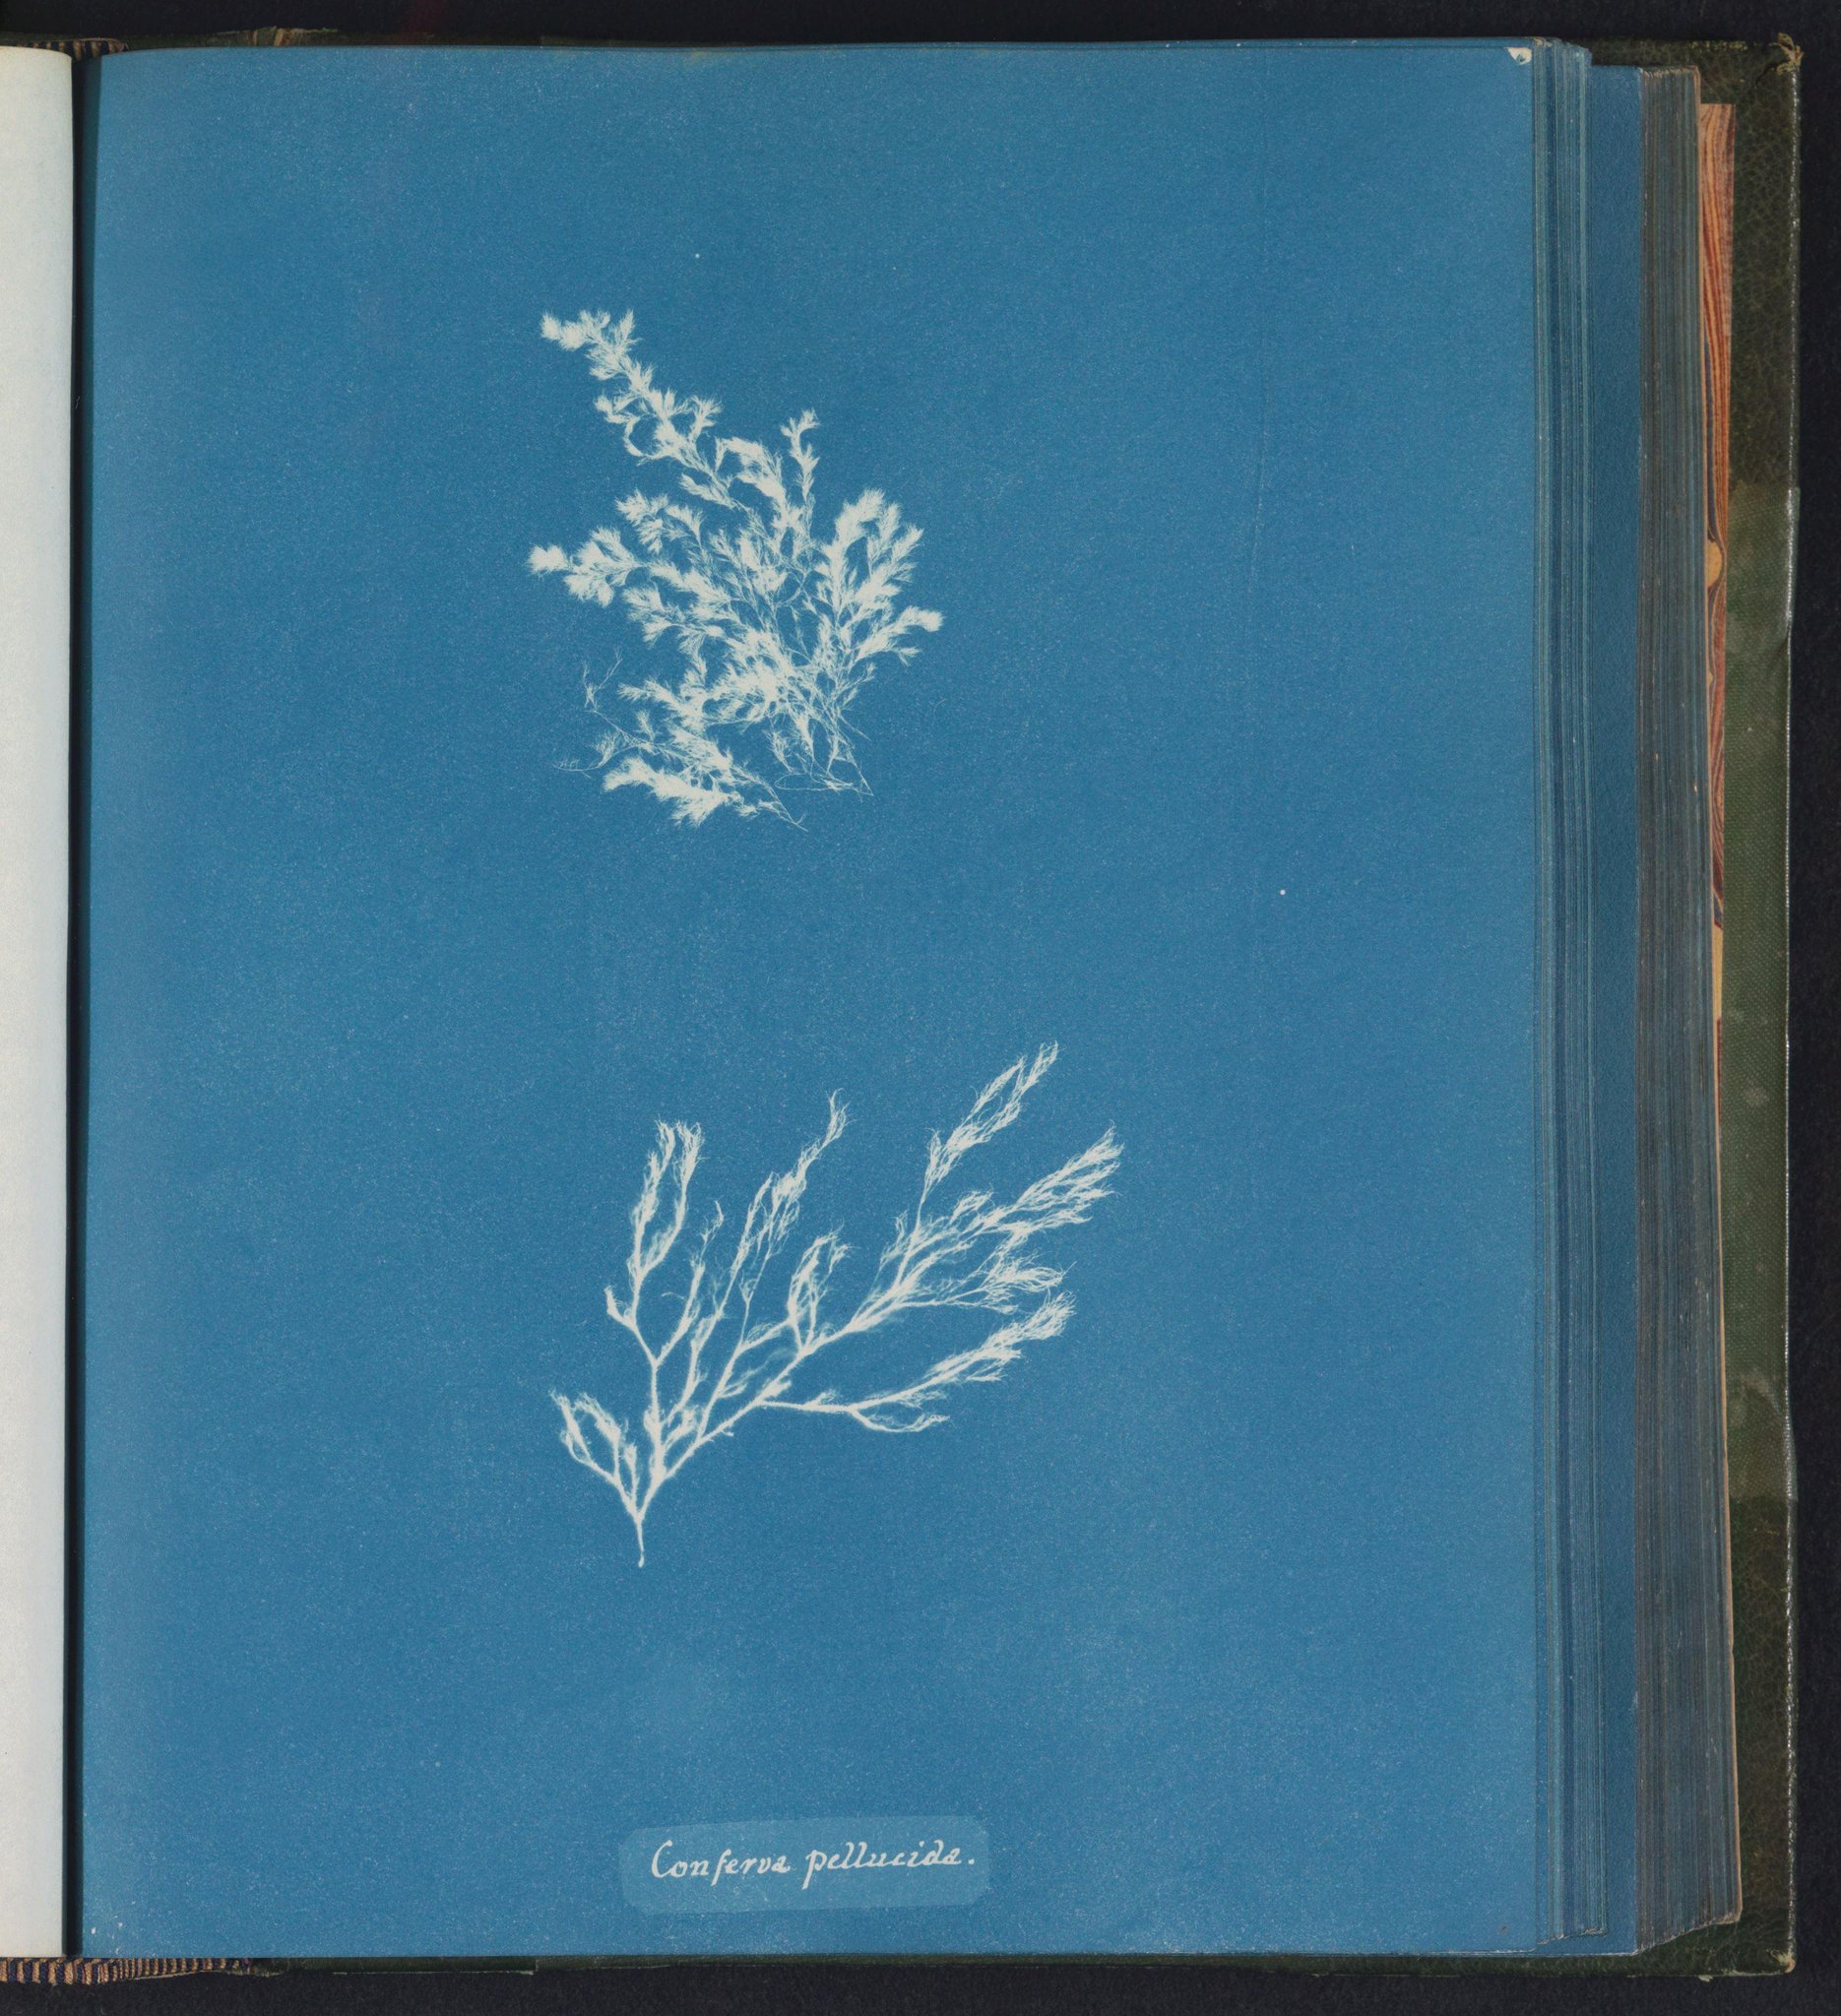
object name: photograph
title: Conferva pellucida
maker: anna atkins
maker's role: fotograaf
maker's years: 1799-1871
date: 1843-1853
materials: photographic support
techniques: cyanotype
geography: united kingdom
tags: algae, seaweed